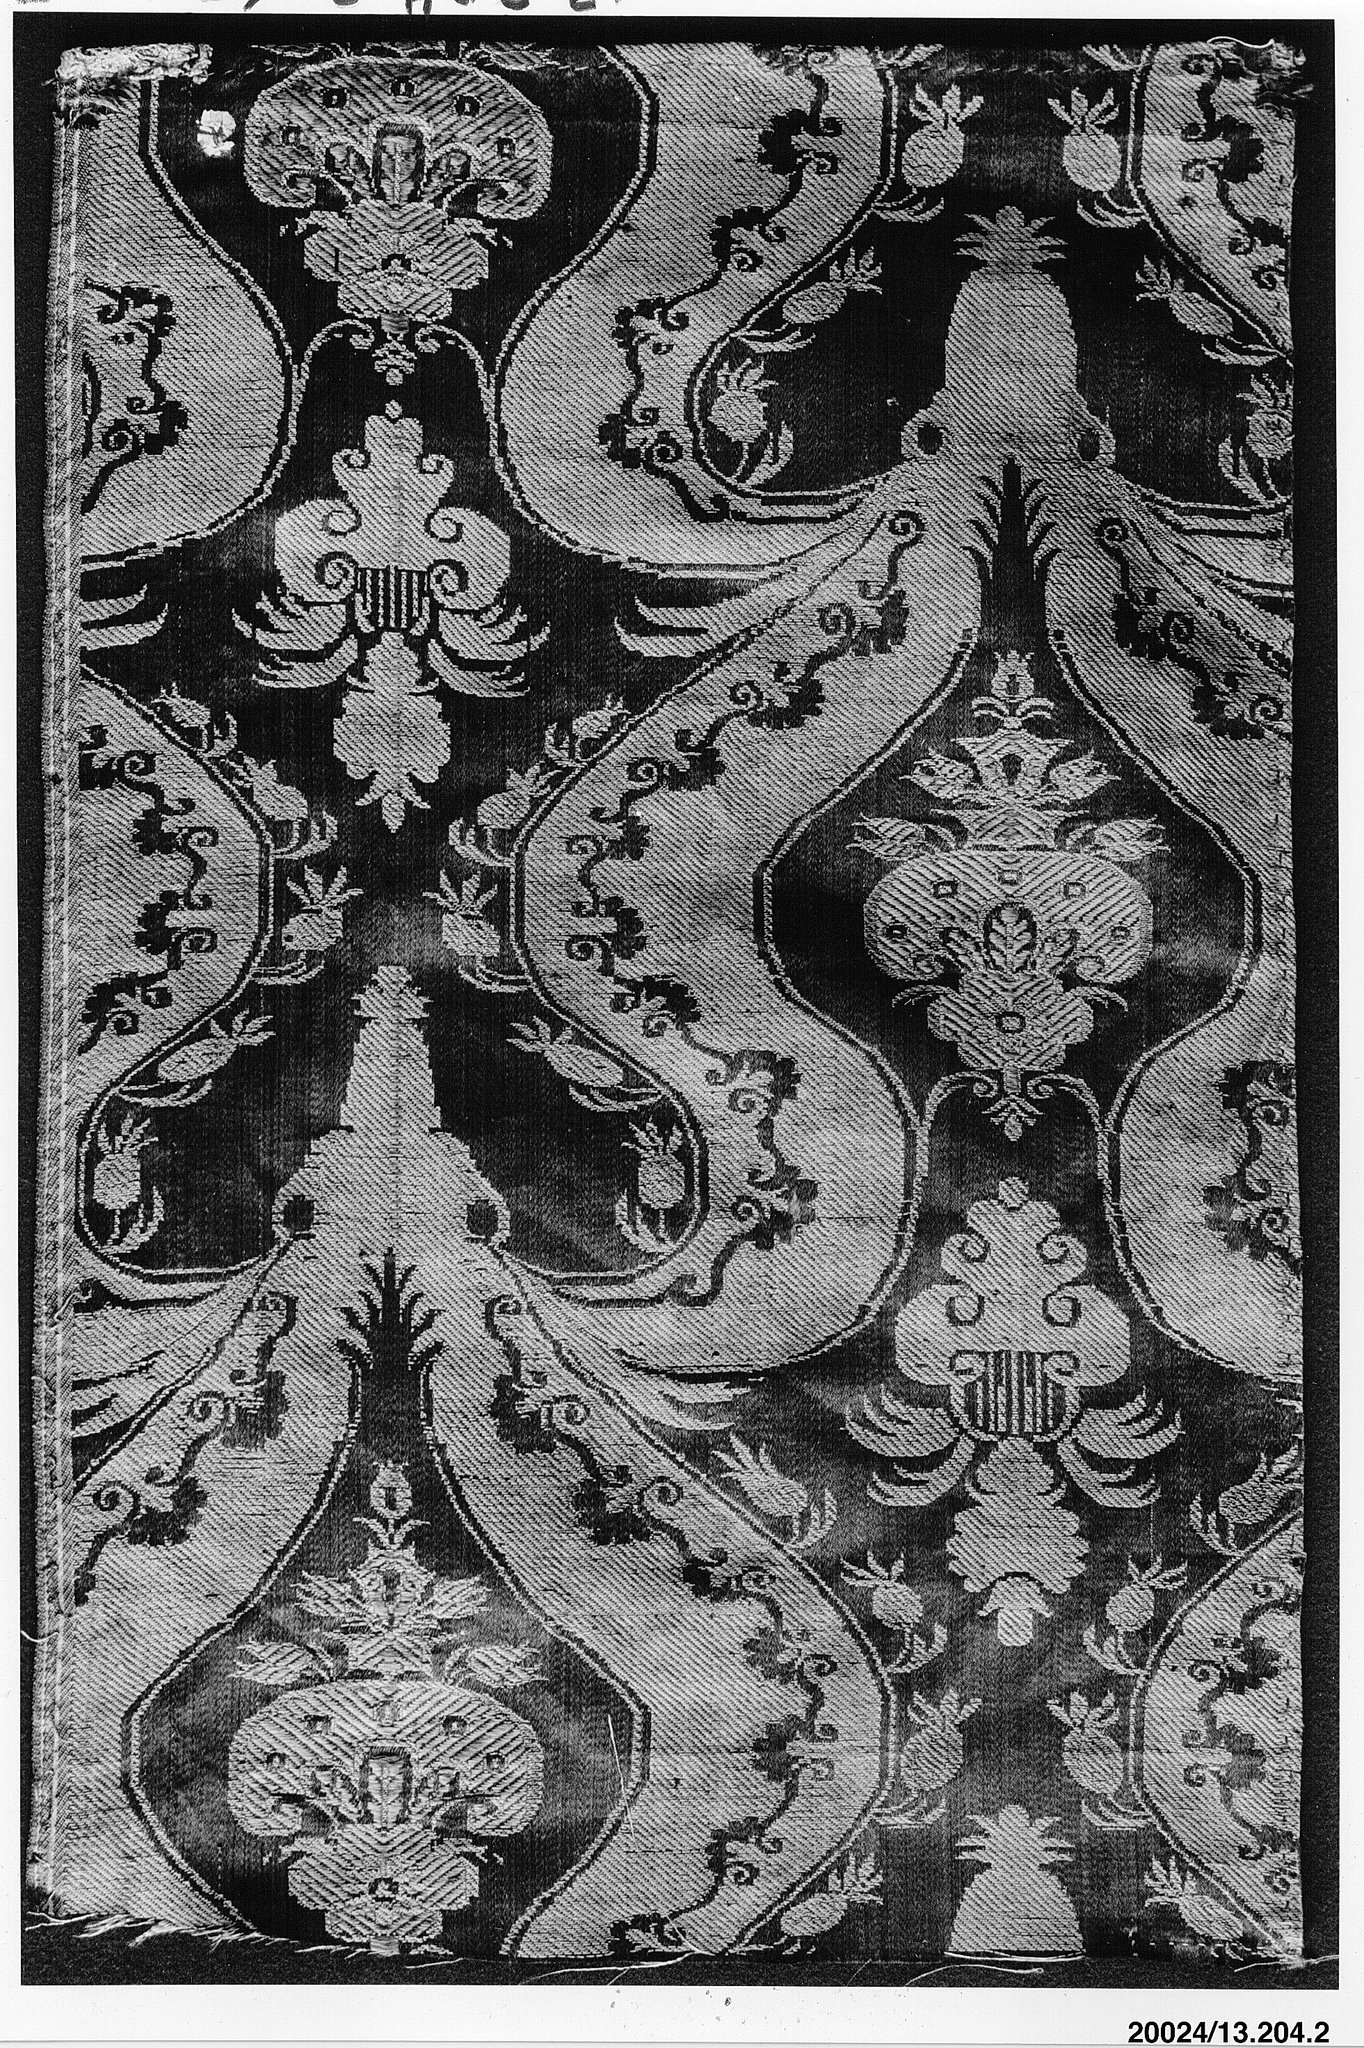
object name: piece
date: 1700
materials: silk